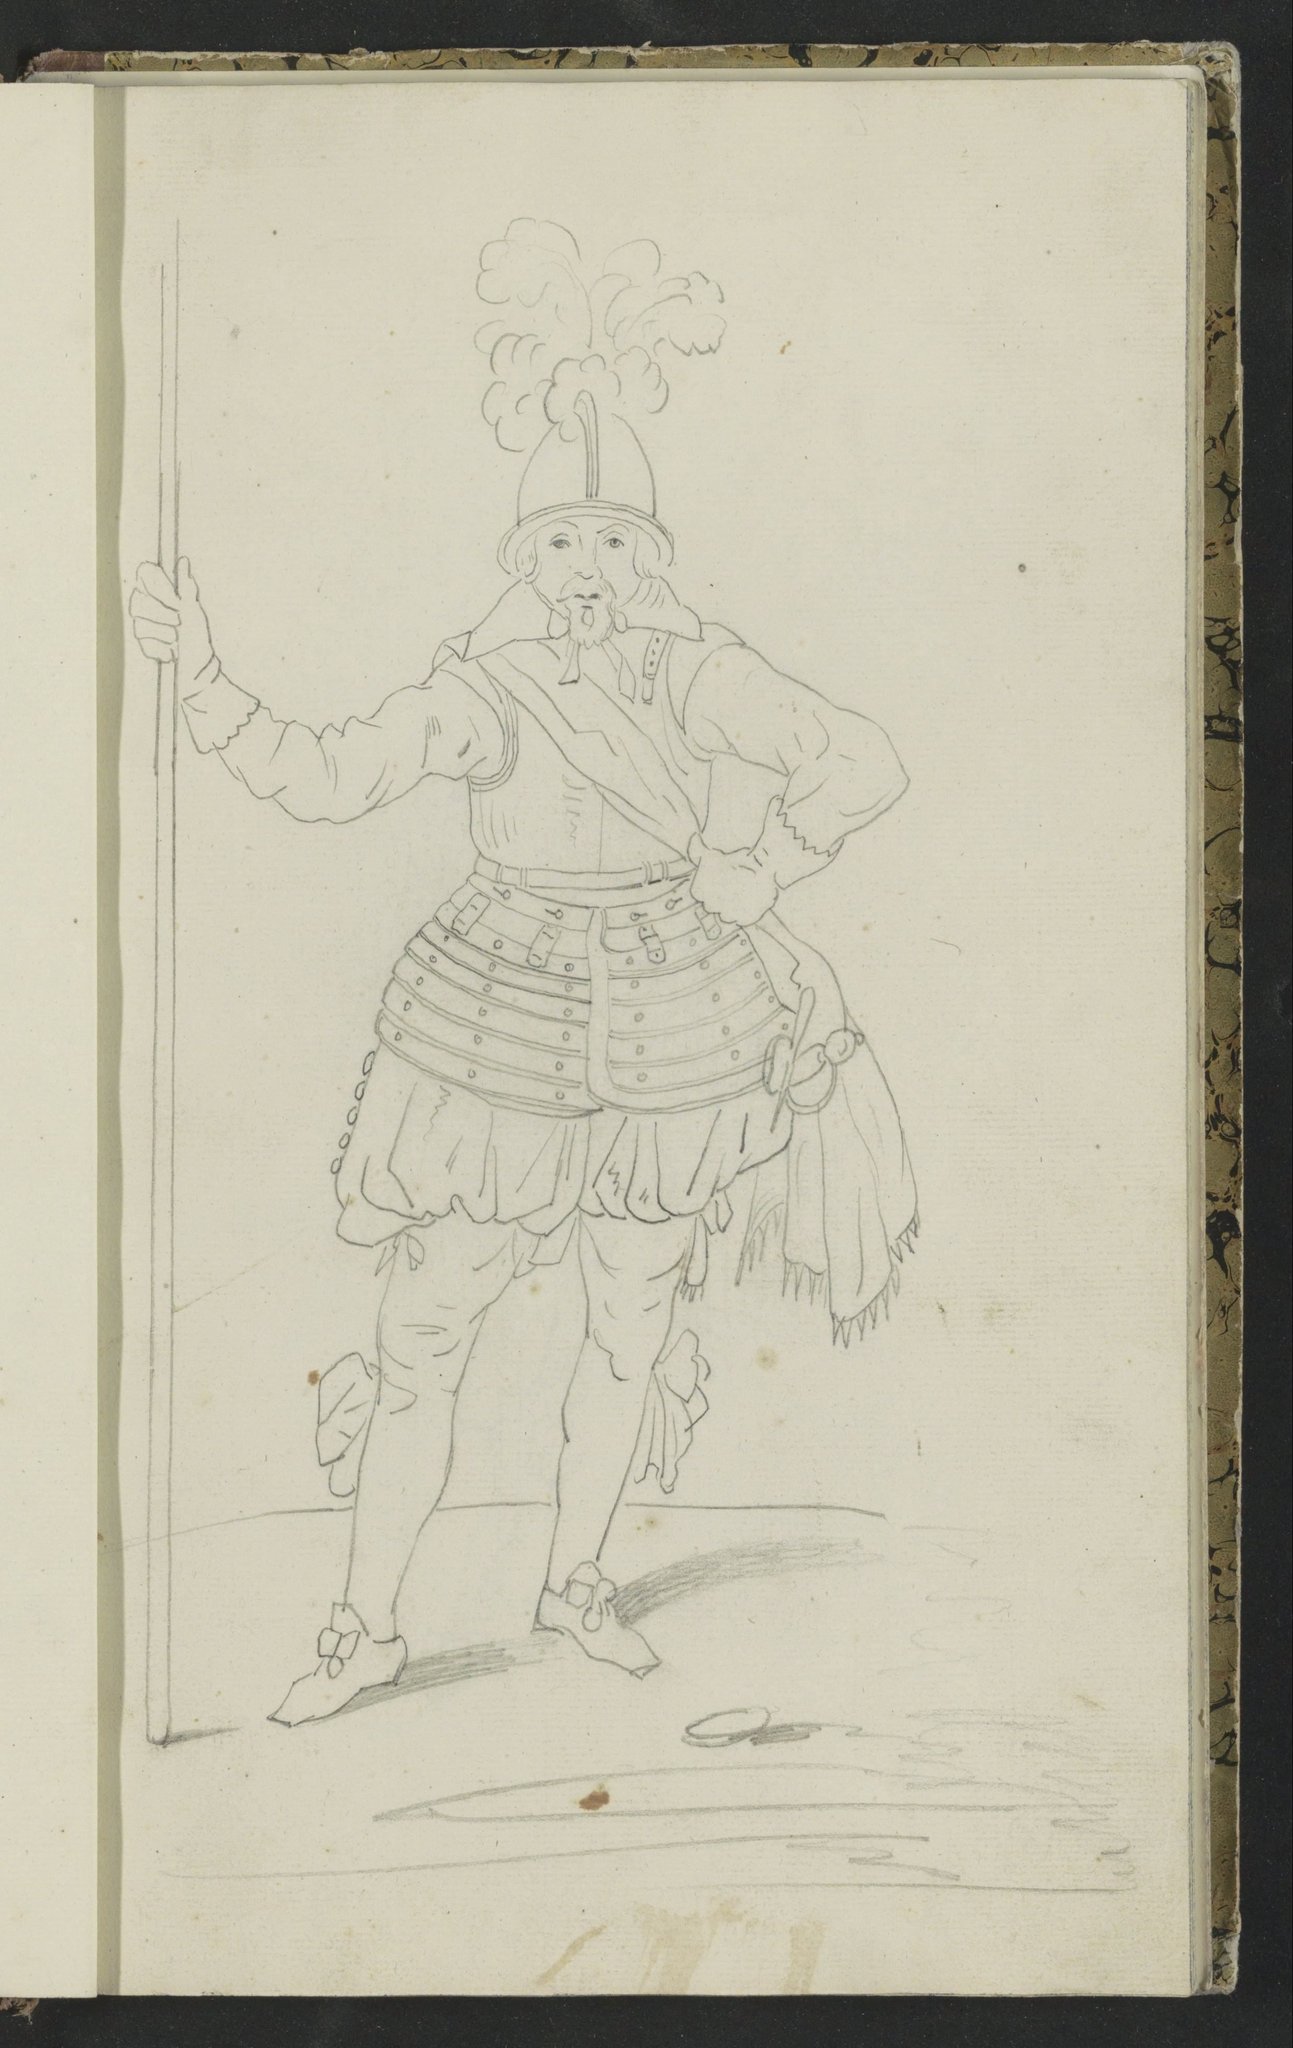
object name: sketchbook leaf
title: Soldaat die zijn spies met de rechterhand rechtop vasthoudt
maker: johannes antonius canta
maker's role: draughtsman, painter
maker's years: 1816-1888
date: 1826-1888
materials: paper, pencil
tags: casting weapons: spear, (military) uniforms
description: Kopie naar Jacob de Gheyns 'Wapenhandelinghe van roers musquetten ende spiessen: achtervolghende de ordre van syn excellentie Maurits prince van Orangie grave van Nassau &c' uit 1607. Blad 14 recto uit een schetsboek en album met 59 bladen.